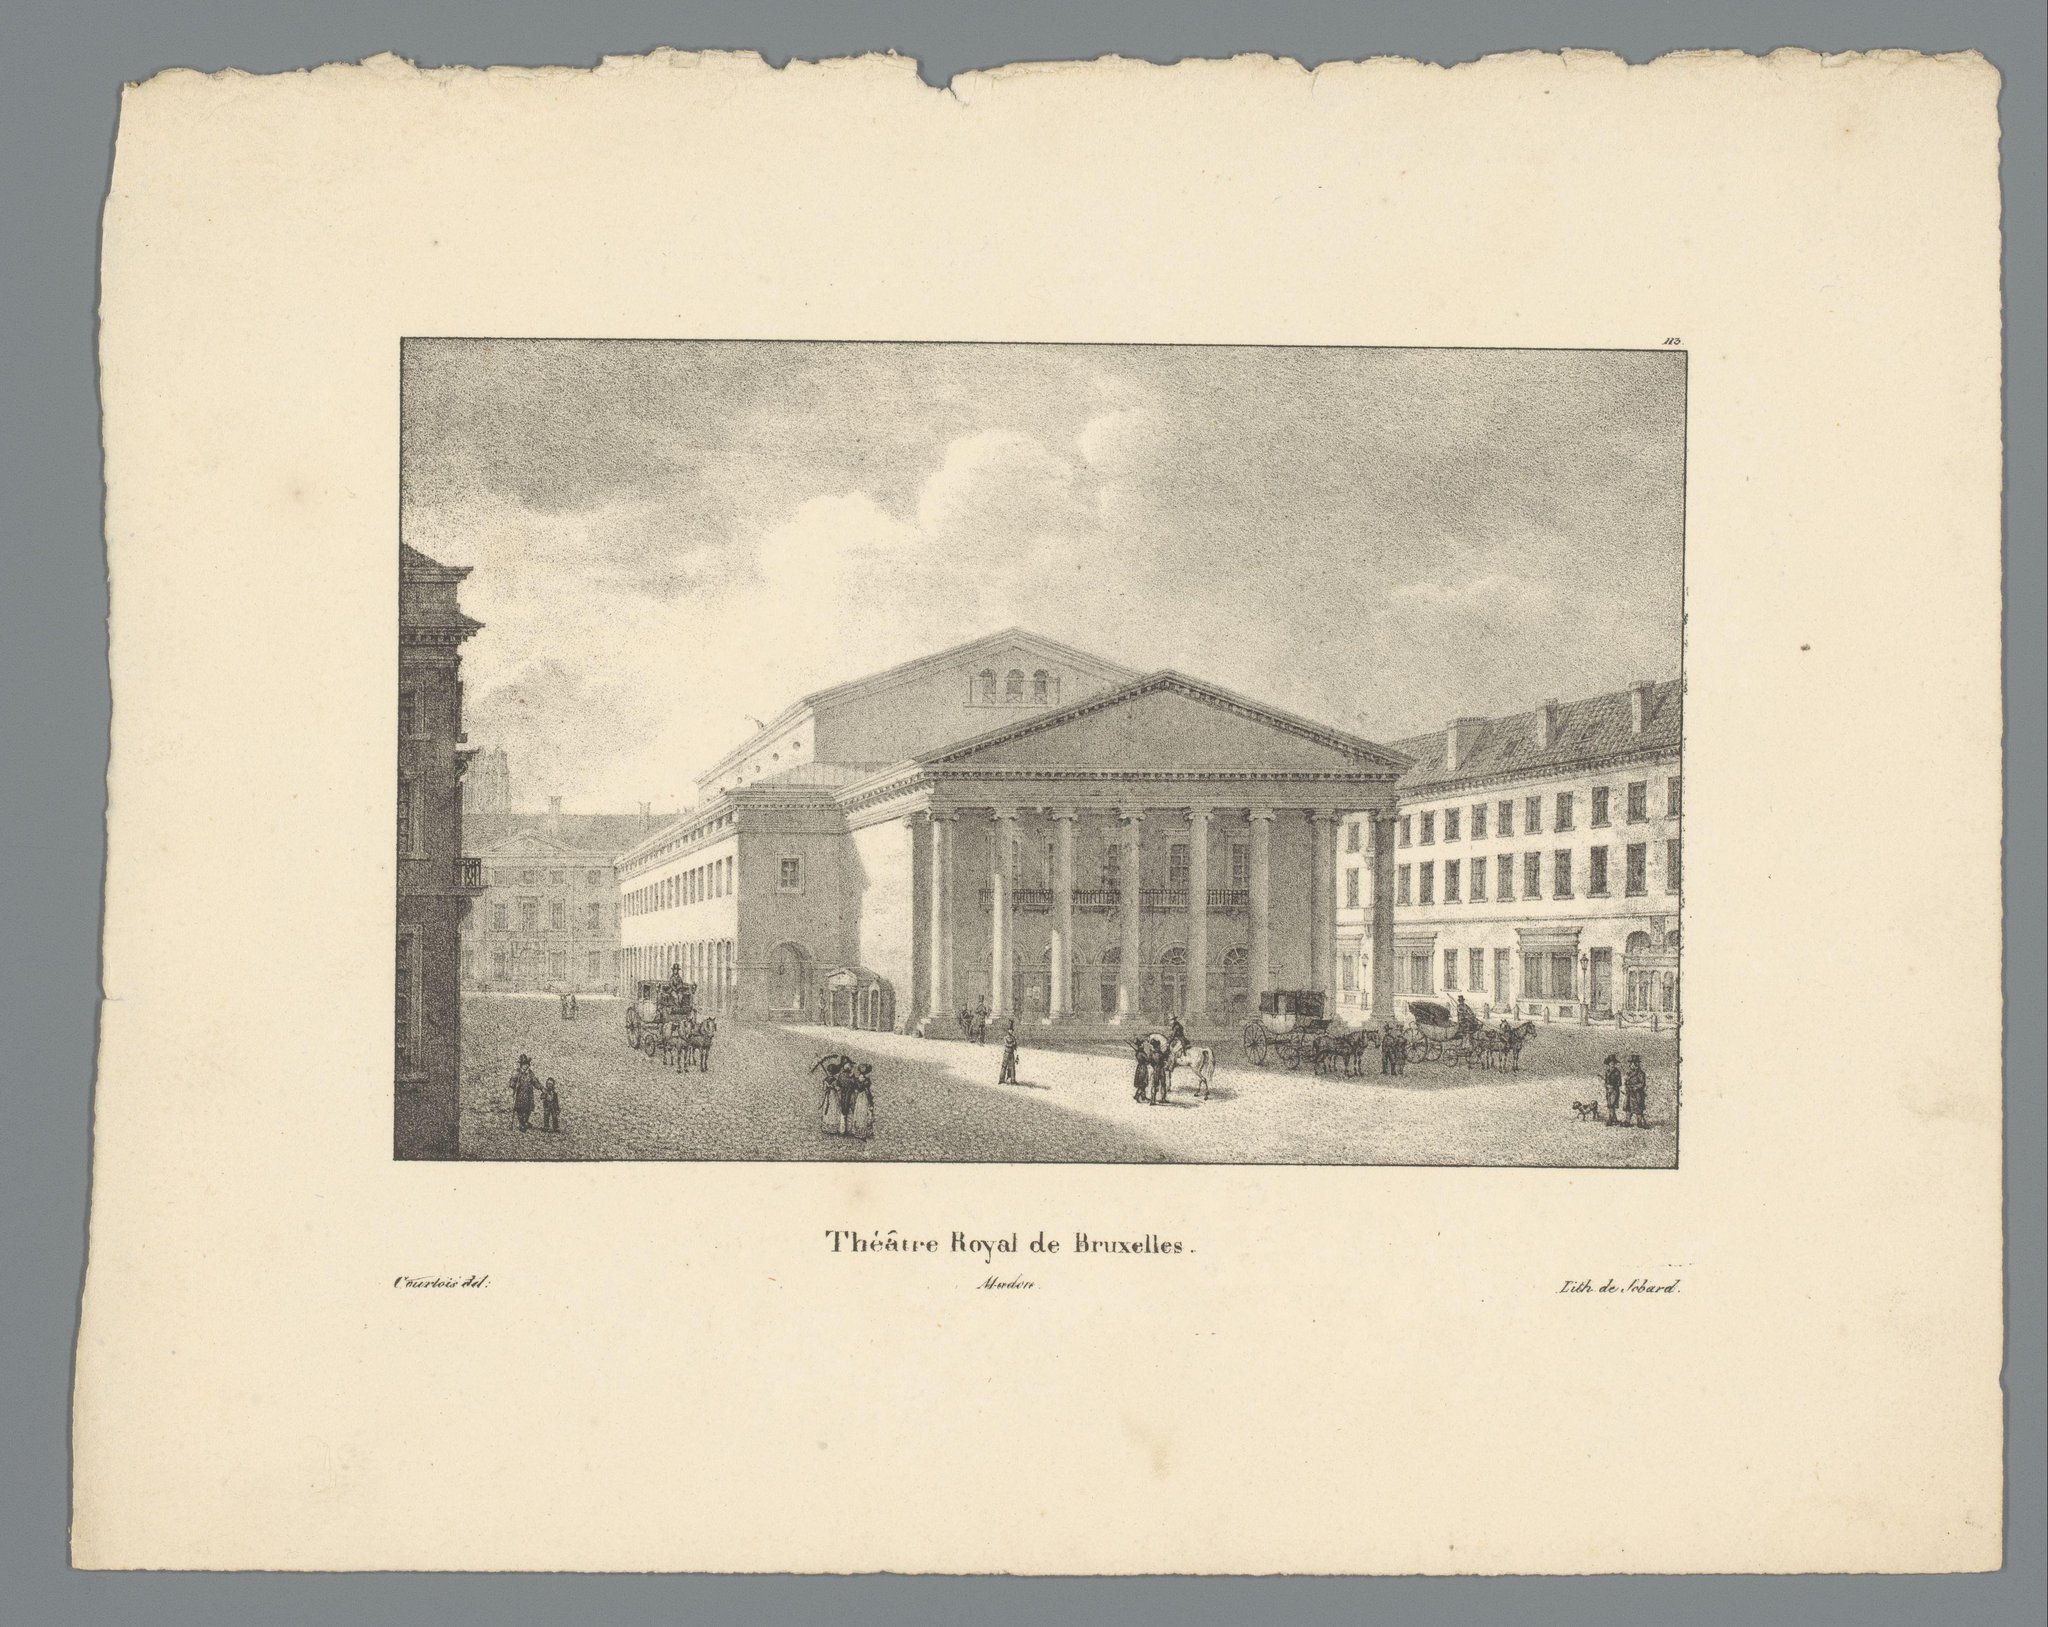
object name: print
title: Théâtre Royal de Bruxelles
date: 1827-1829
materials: paper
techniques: lithograph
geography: brussels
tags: theatre (building)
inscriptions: collector's mark: Lugt 2228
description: Prent waarschijnlijk uit de serie: "Chateaux et monumens des Pays-Bas", gedrukt bij de Jobard frères. Er verschenen tevens tekstbladen met toelichting bij deze prenten. In de coll. Rijksmuseum Amsterdam bevinden zich twee banden met daarin de prenten en bijbehorende tekstbladen gebonden. Daarin bevindt deze prent zich niet.